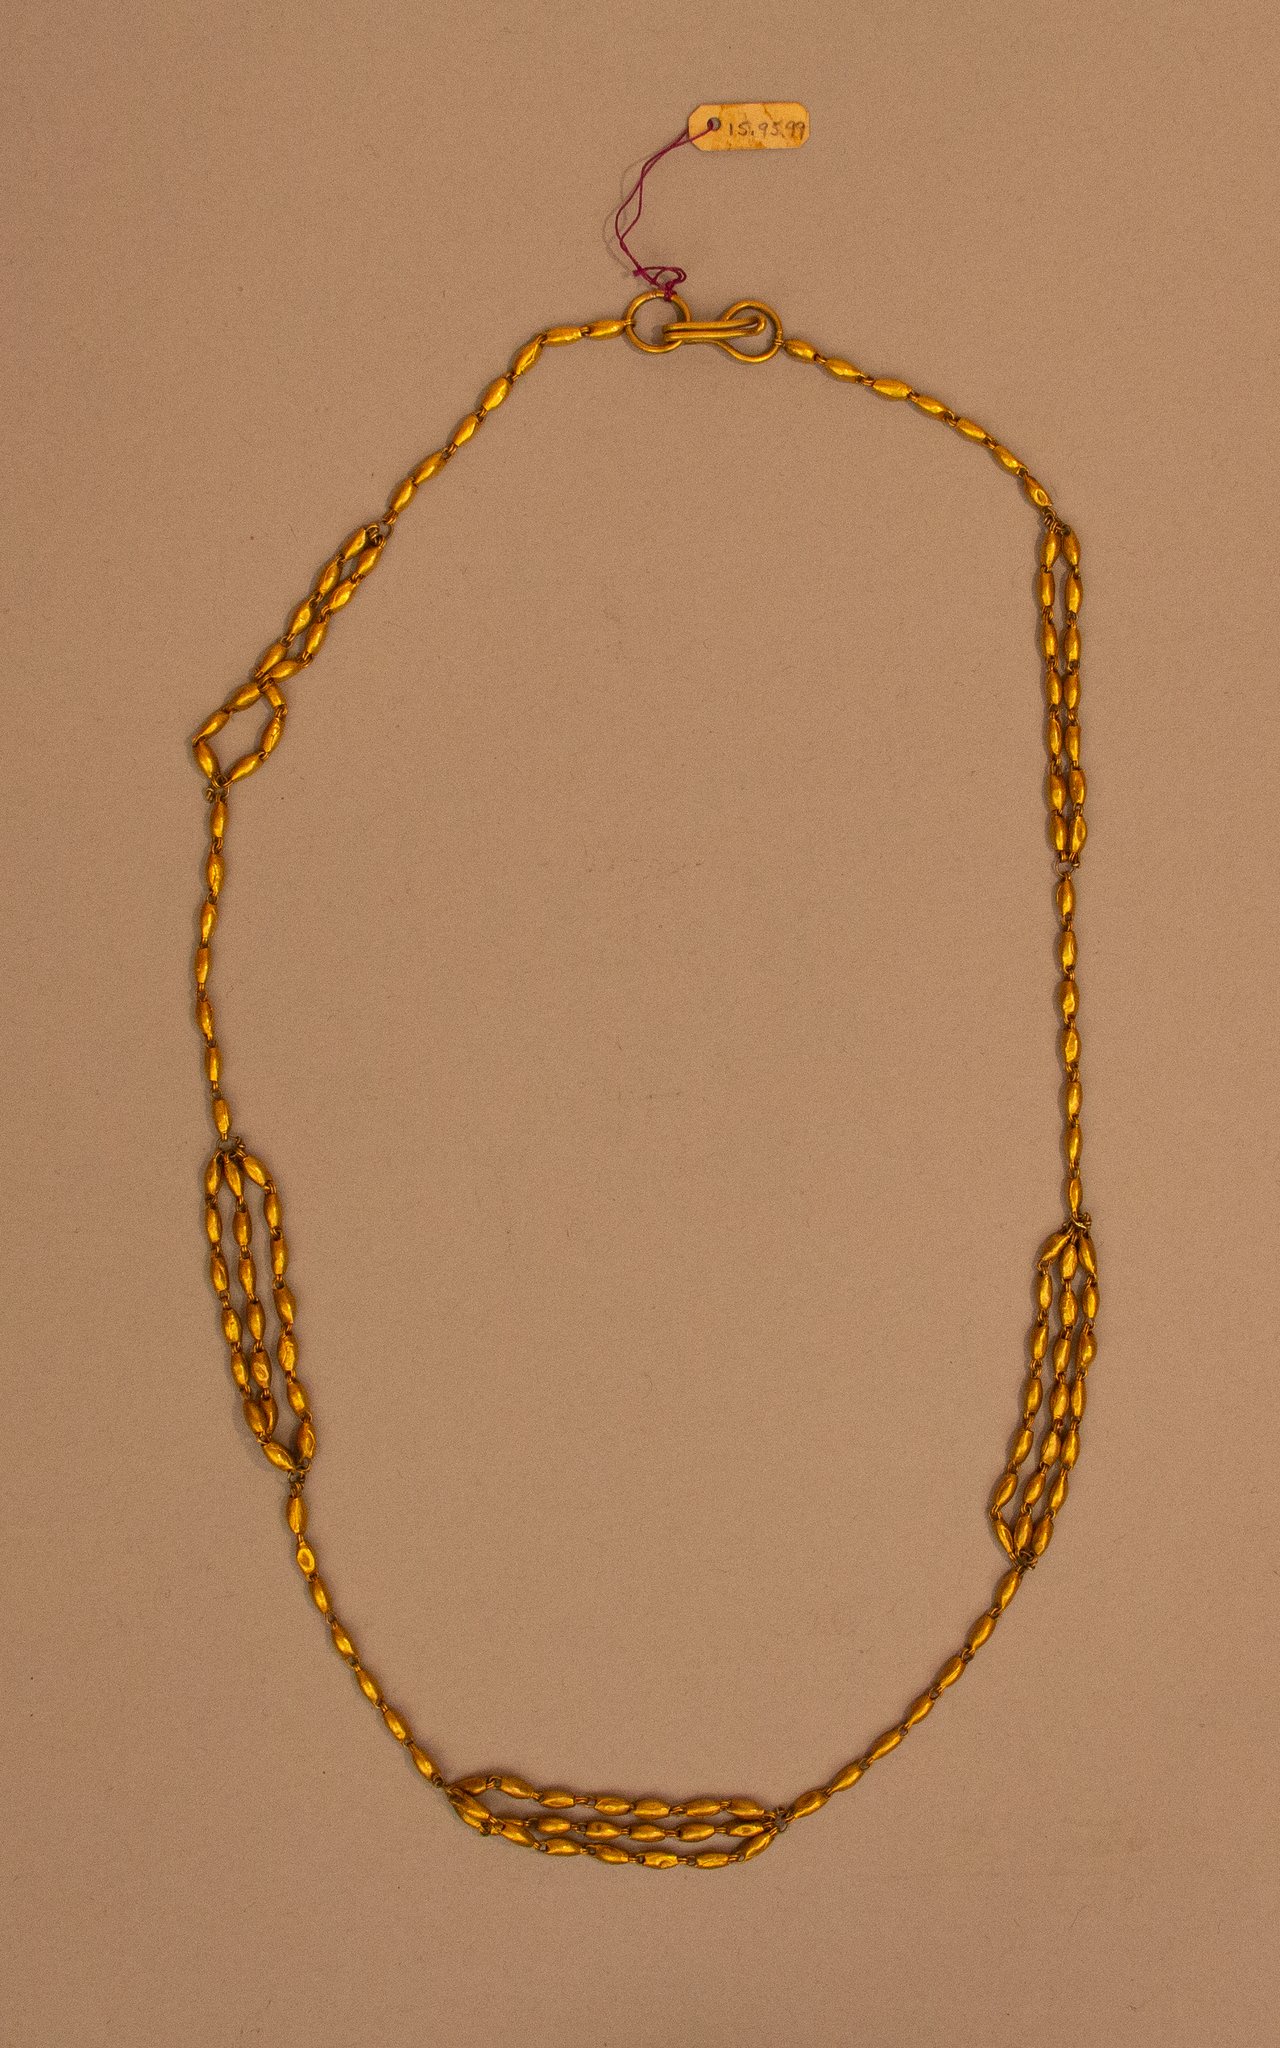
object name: necklace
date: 1701-1900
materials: gold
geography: india